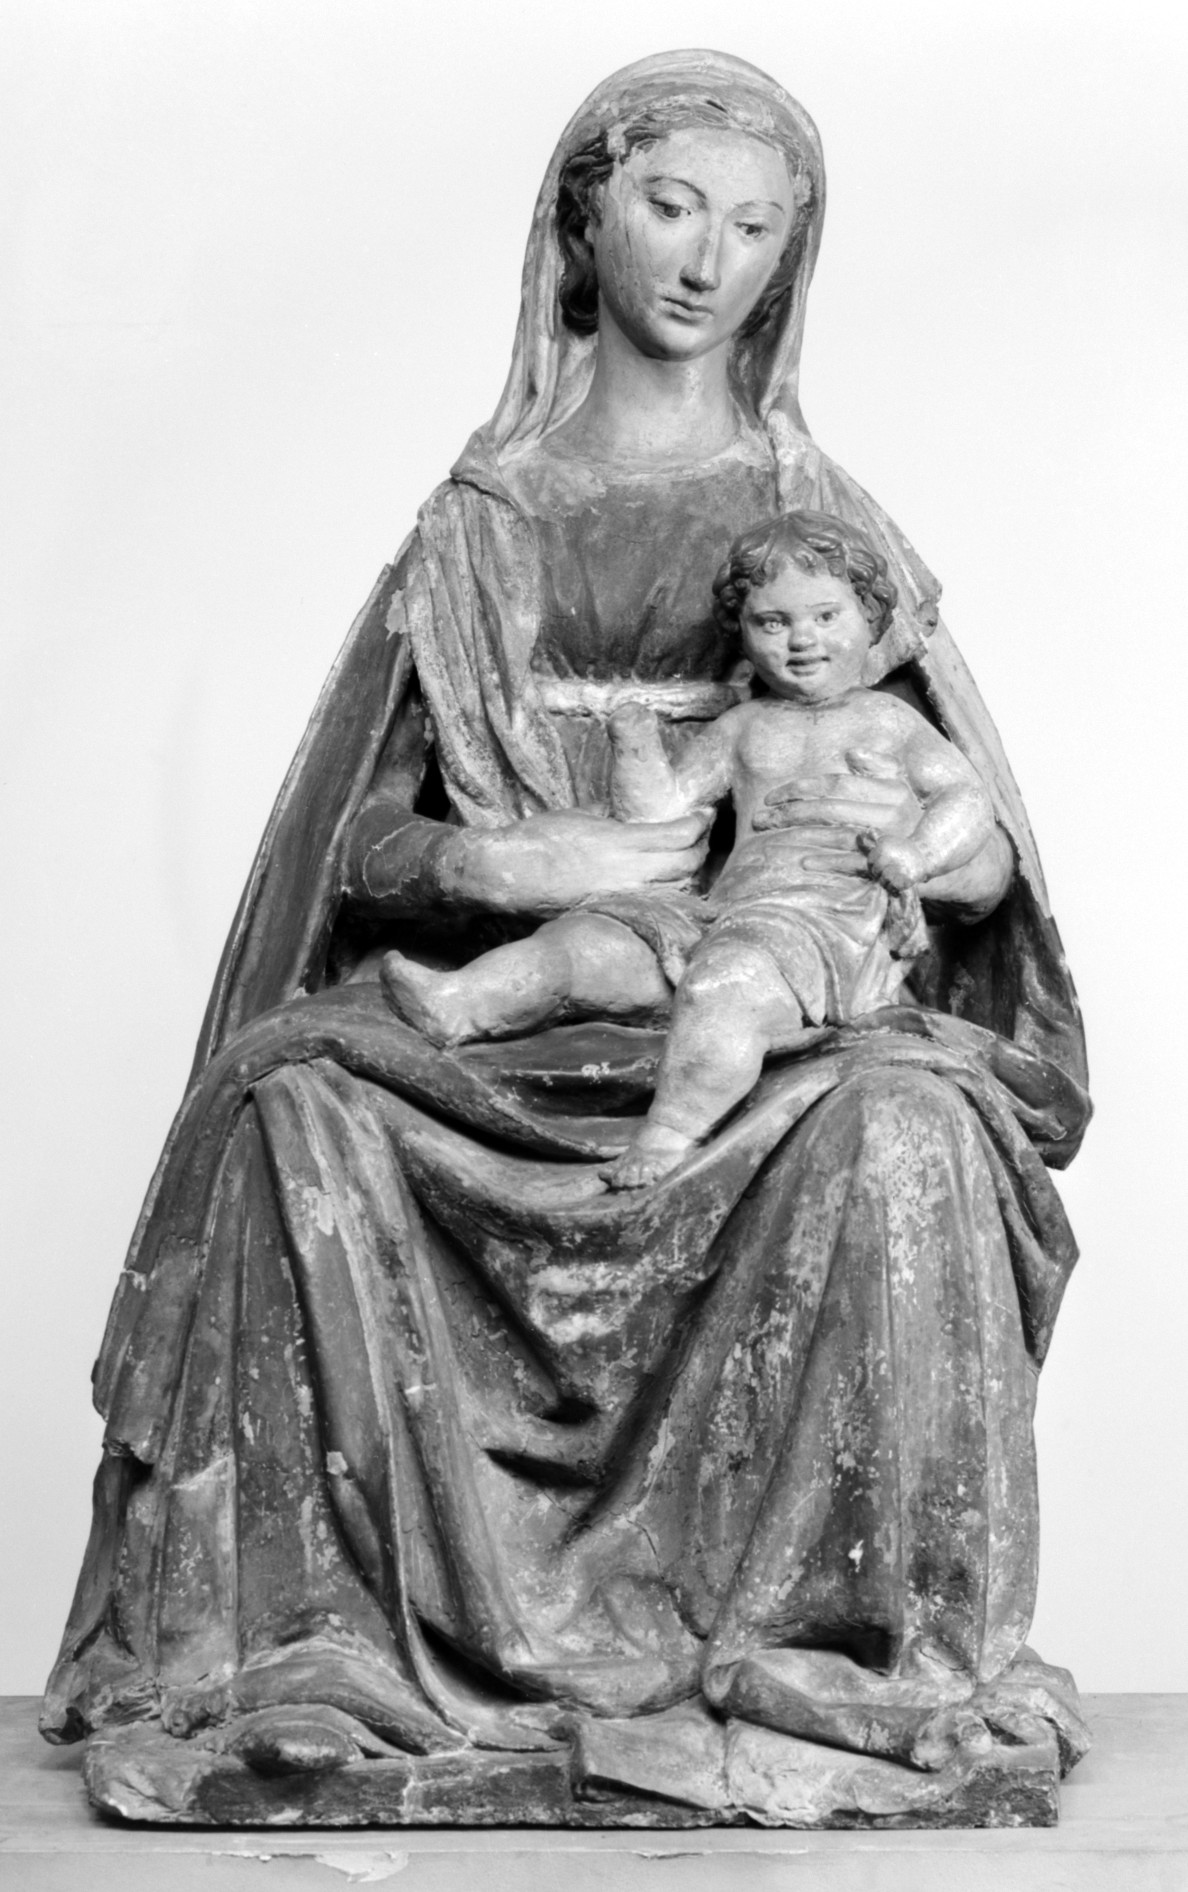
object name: statue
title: Madonna and Child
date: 1466-1499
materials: terracotta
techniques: painting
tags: madonna and child